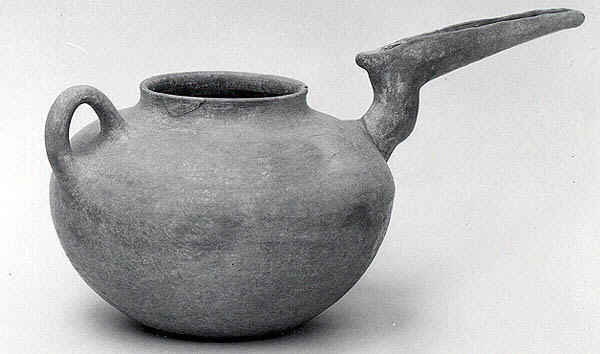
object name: jar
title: Spouted jar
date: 1400-1200 BCE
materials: ceramic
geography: iran